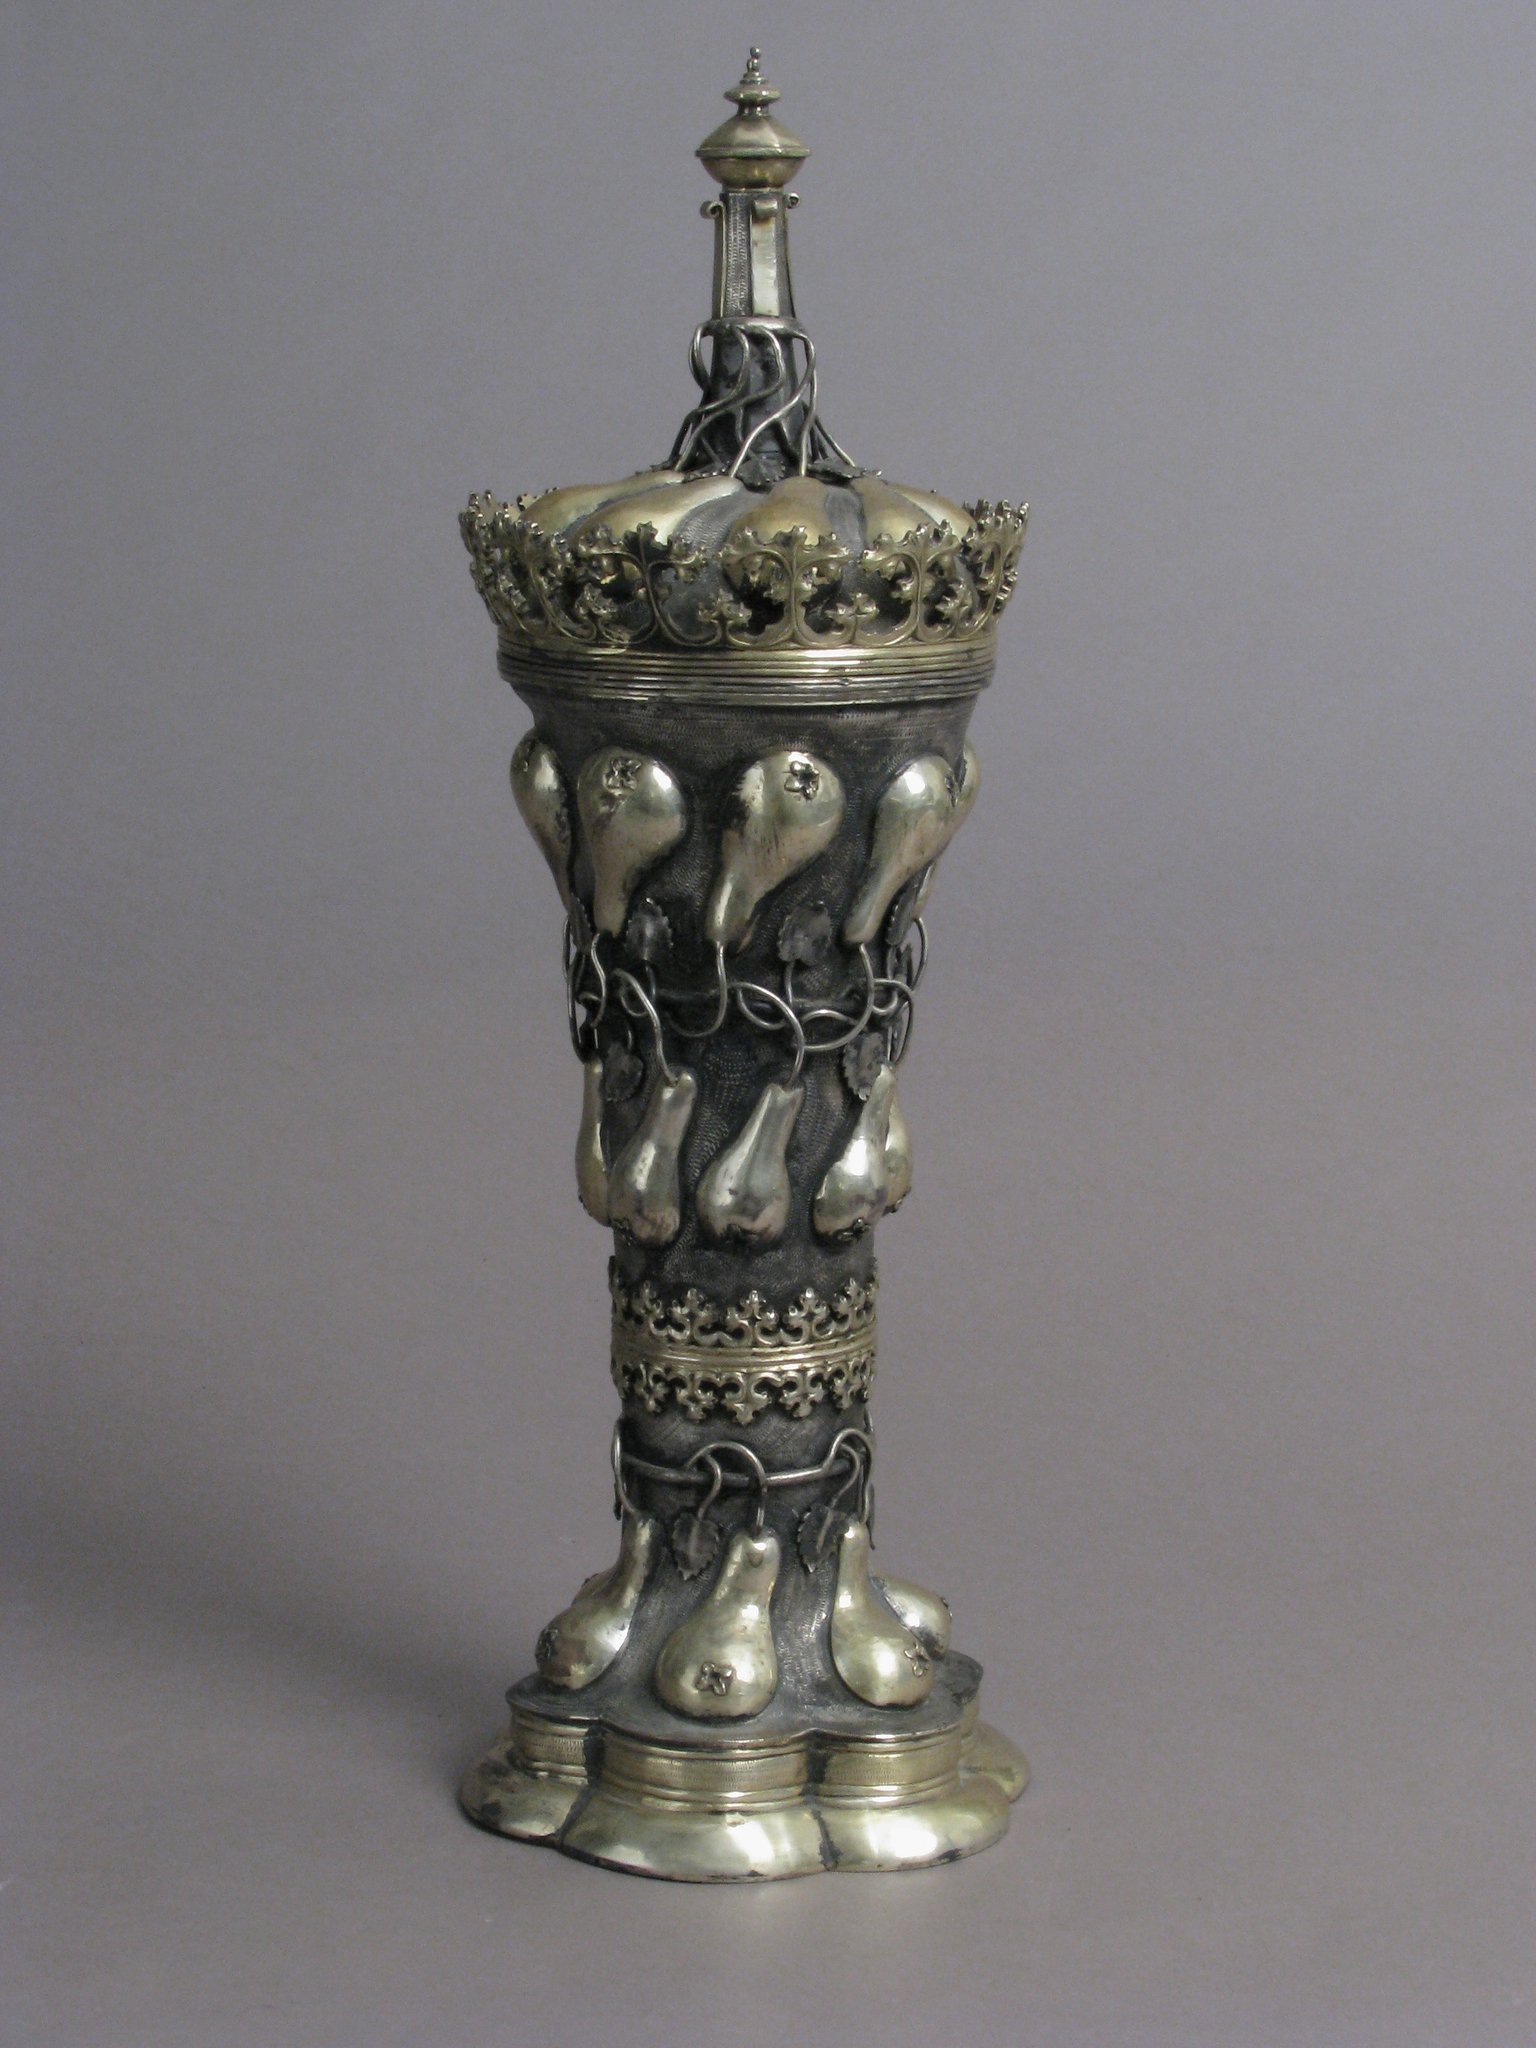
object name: beaker with cover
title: Beaker and Cover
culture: german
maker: friedrich hillebrand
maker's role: artist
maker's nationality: german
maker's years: 1580-1608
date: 1801-1900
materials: gilt, silver